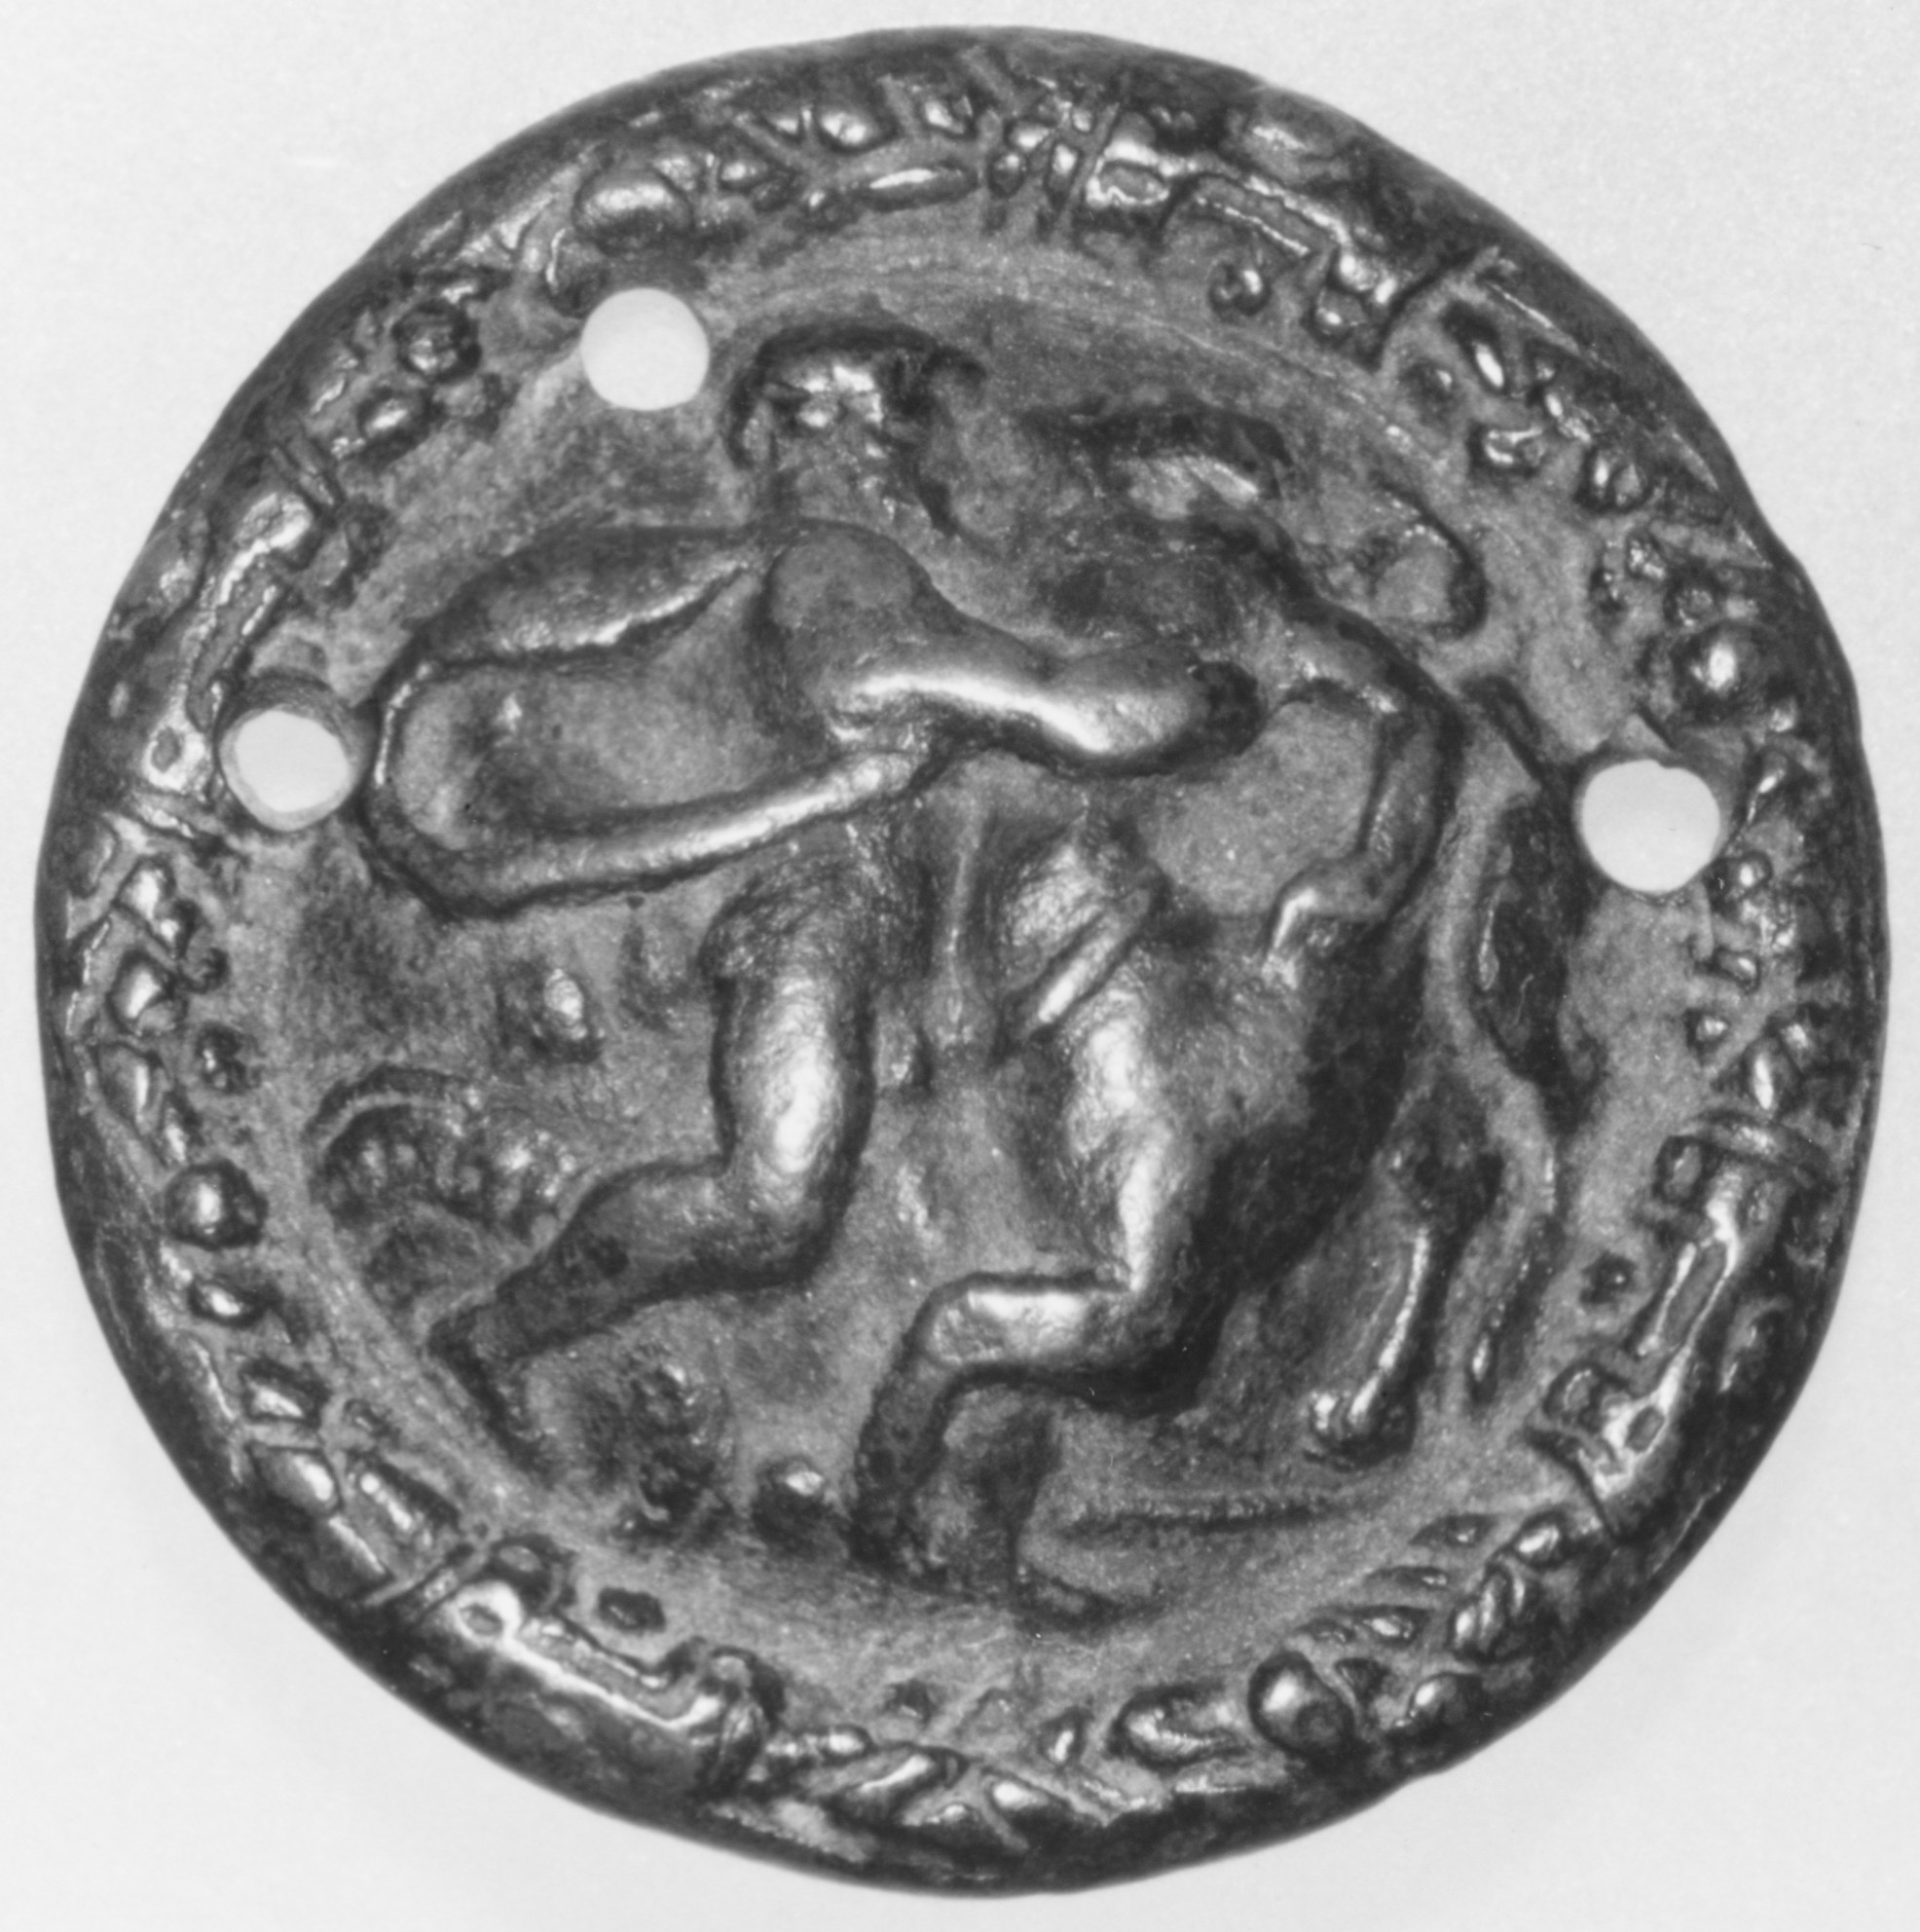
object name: plaquette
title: Hercules and the Centaur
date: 1467-1500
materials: bronze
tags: hercules,centaurs